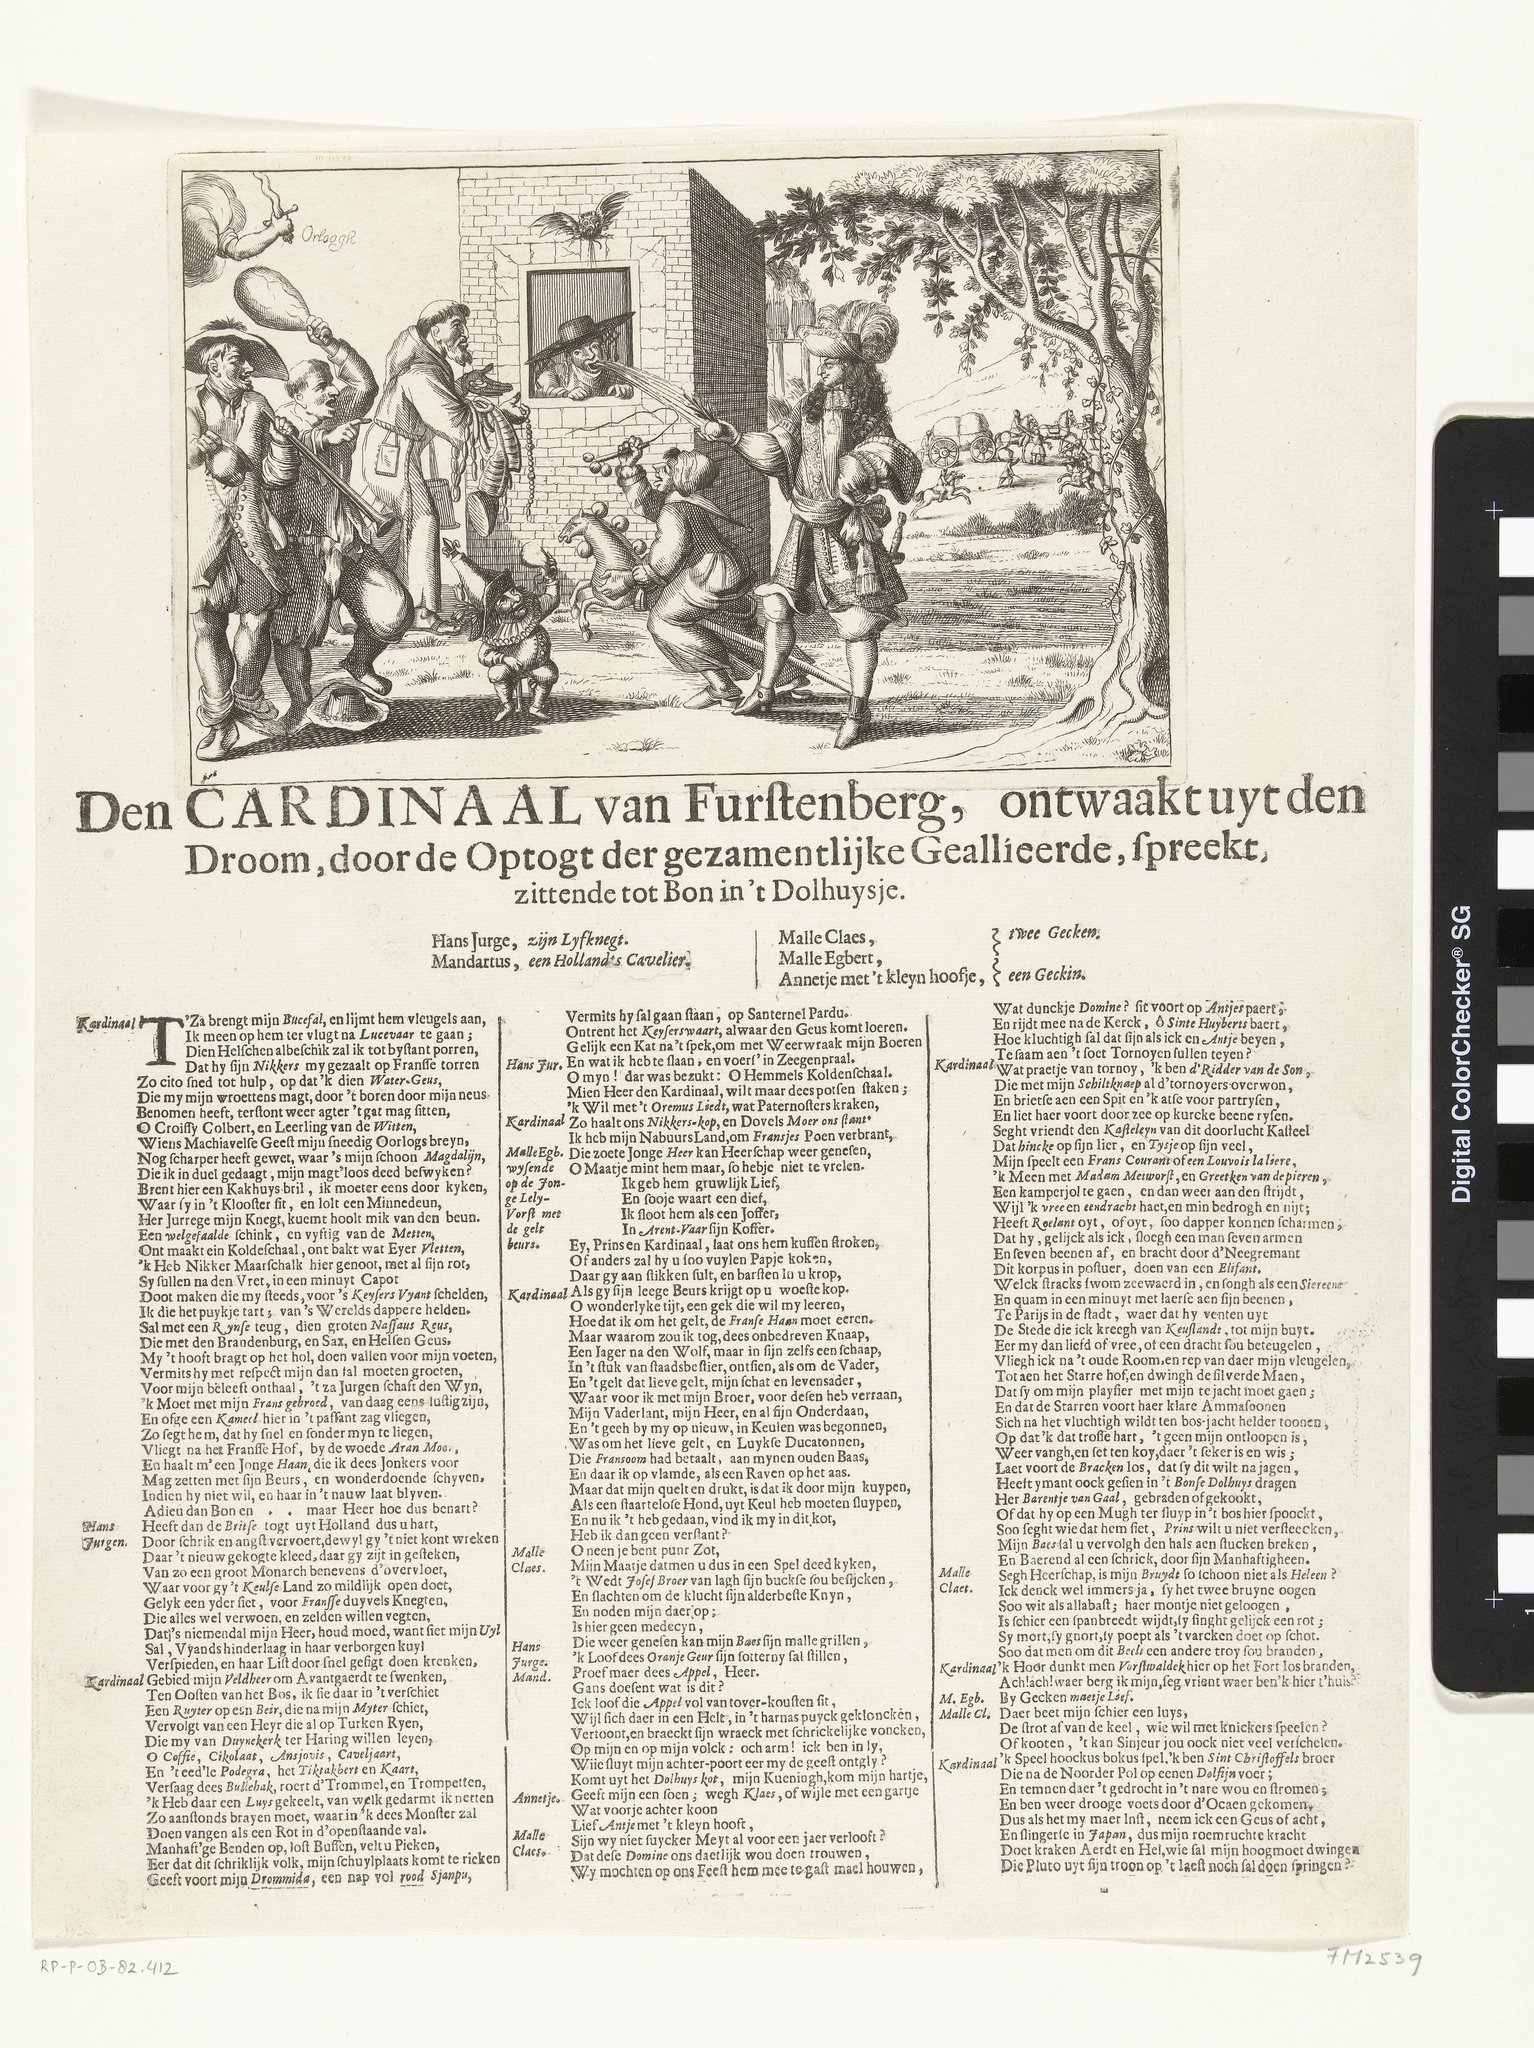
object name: cartoon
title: Spotprent op prins Wilhelm von Fürstenberg, 1674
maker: Anonymous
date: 1674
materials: paper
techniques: etching, letterpress printing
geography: northern netherlands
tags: william iii (prince of orange and king of england, scotland, and ireland), paris, lunatic asylum, mental home, political caricatures and satires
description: Spotprent op de kardinaal prins Wilhelm von Fürstenberg na het sluiten van de vrede met Engeland door de Republiek op 19 februari 1674 en het gevangen nemen van prins von Fürstenberg op 16 februari 1674. De kardinaal bij het raam in een gekkenhuisje, buiten drie gekken, een monnik en de Hollandse edelman die hem een oranjeappel aanbiedt. Met een spotvers in 3 kolommen.